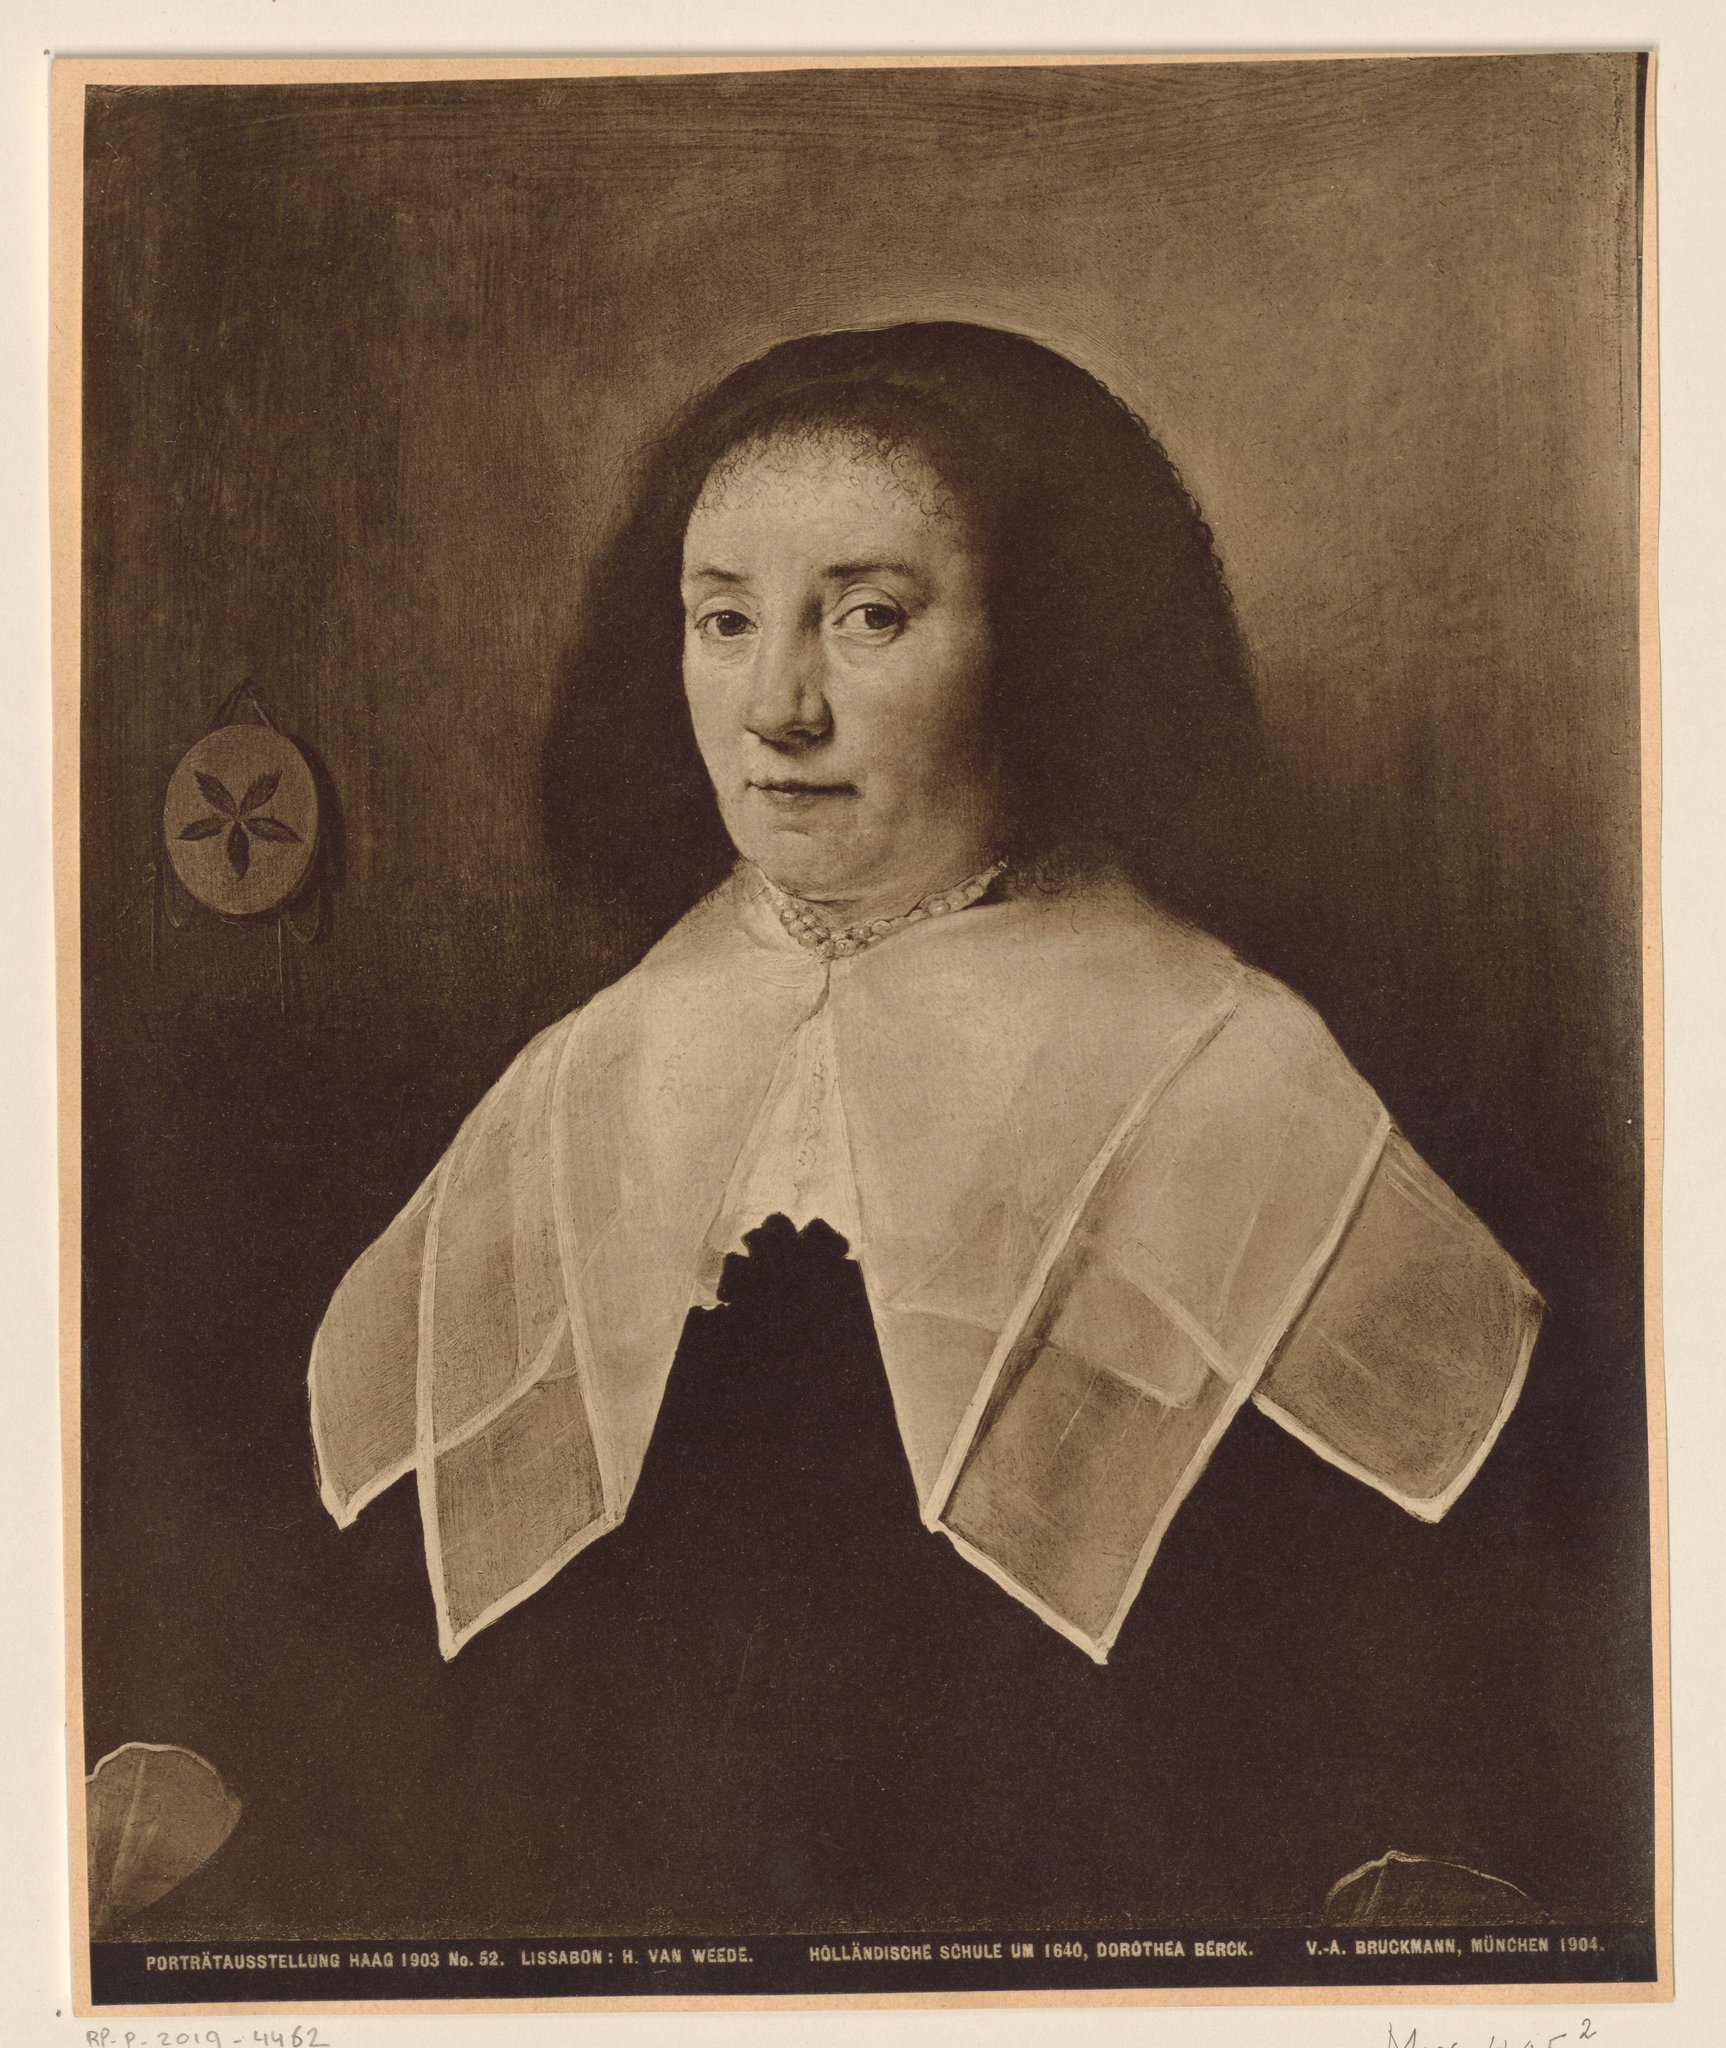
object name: photomechanical print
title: Portret van Dorothea Coymans-Berck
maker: Anonymous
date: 1904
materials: paper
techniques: photograph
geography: munich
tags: historical persons - bb - woman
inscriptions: collector's mark: Lugt 2228